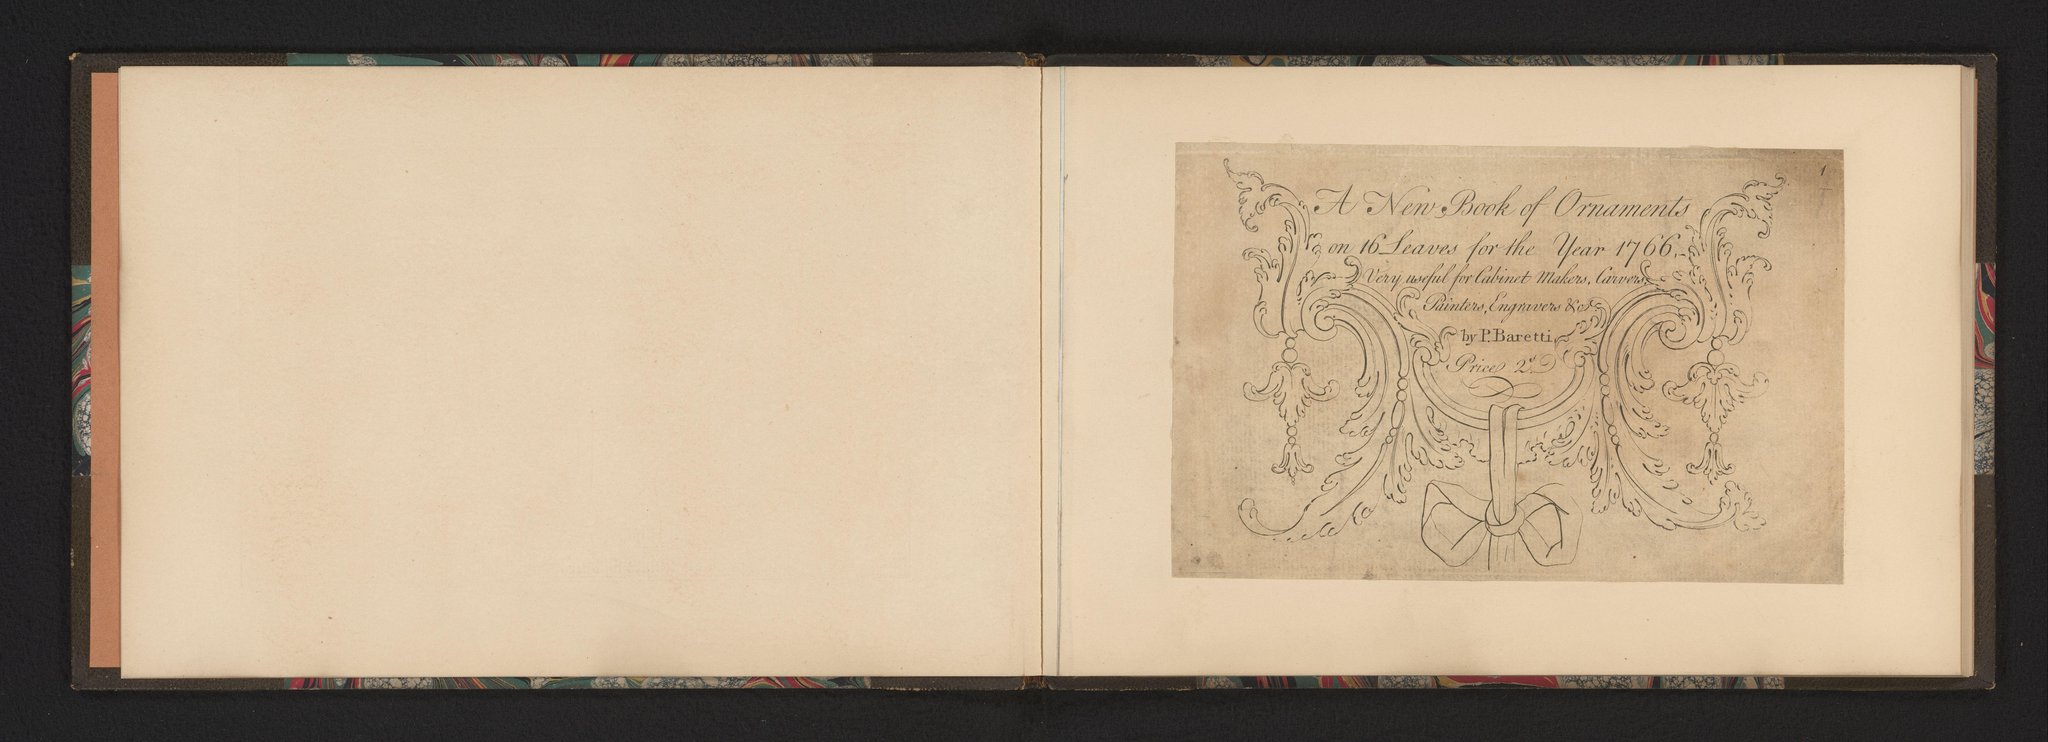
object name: titelprent, frontispice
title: Titelprent van 'A New Book of Ornaments'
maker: p. baretti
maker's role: print maker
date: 1766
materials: paper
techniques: engraving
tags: ornaments ~ art, title-page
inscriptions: number: ‘1’, signature: ‘by P. Baretti’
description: Ingeplakte titelprent van ornamentele versiering schematisch weergegeven met in het midden de titel: ''A New Book of Ornaments on 16 Leaves for the Year 1766. Very useful for Cabinet Makers, Carvers, Painters, Engravers &co. by P. Baretto. Price 2.''. Prent maakt deel uit van een album.